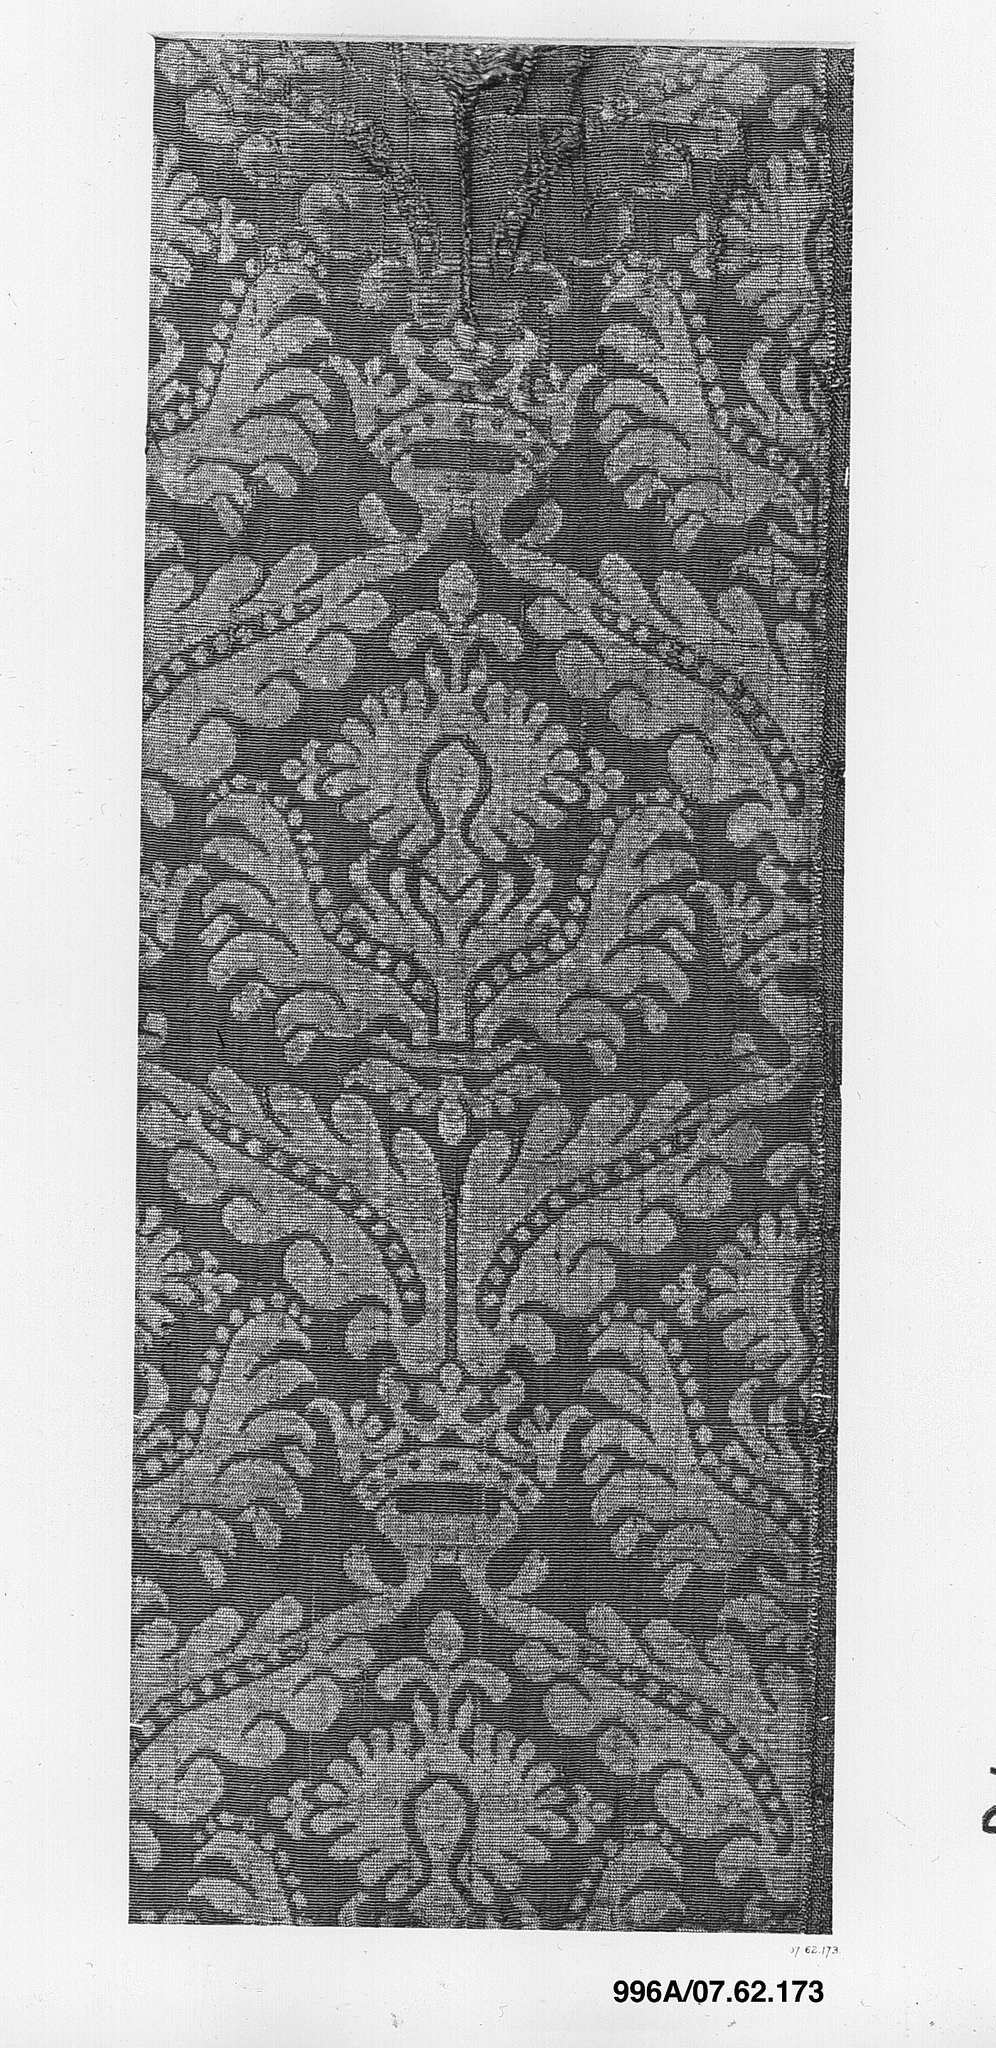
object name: piece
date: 1501-1600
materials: metal thread, silk